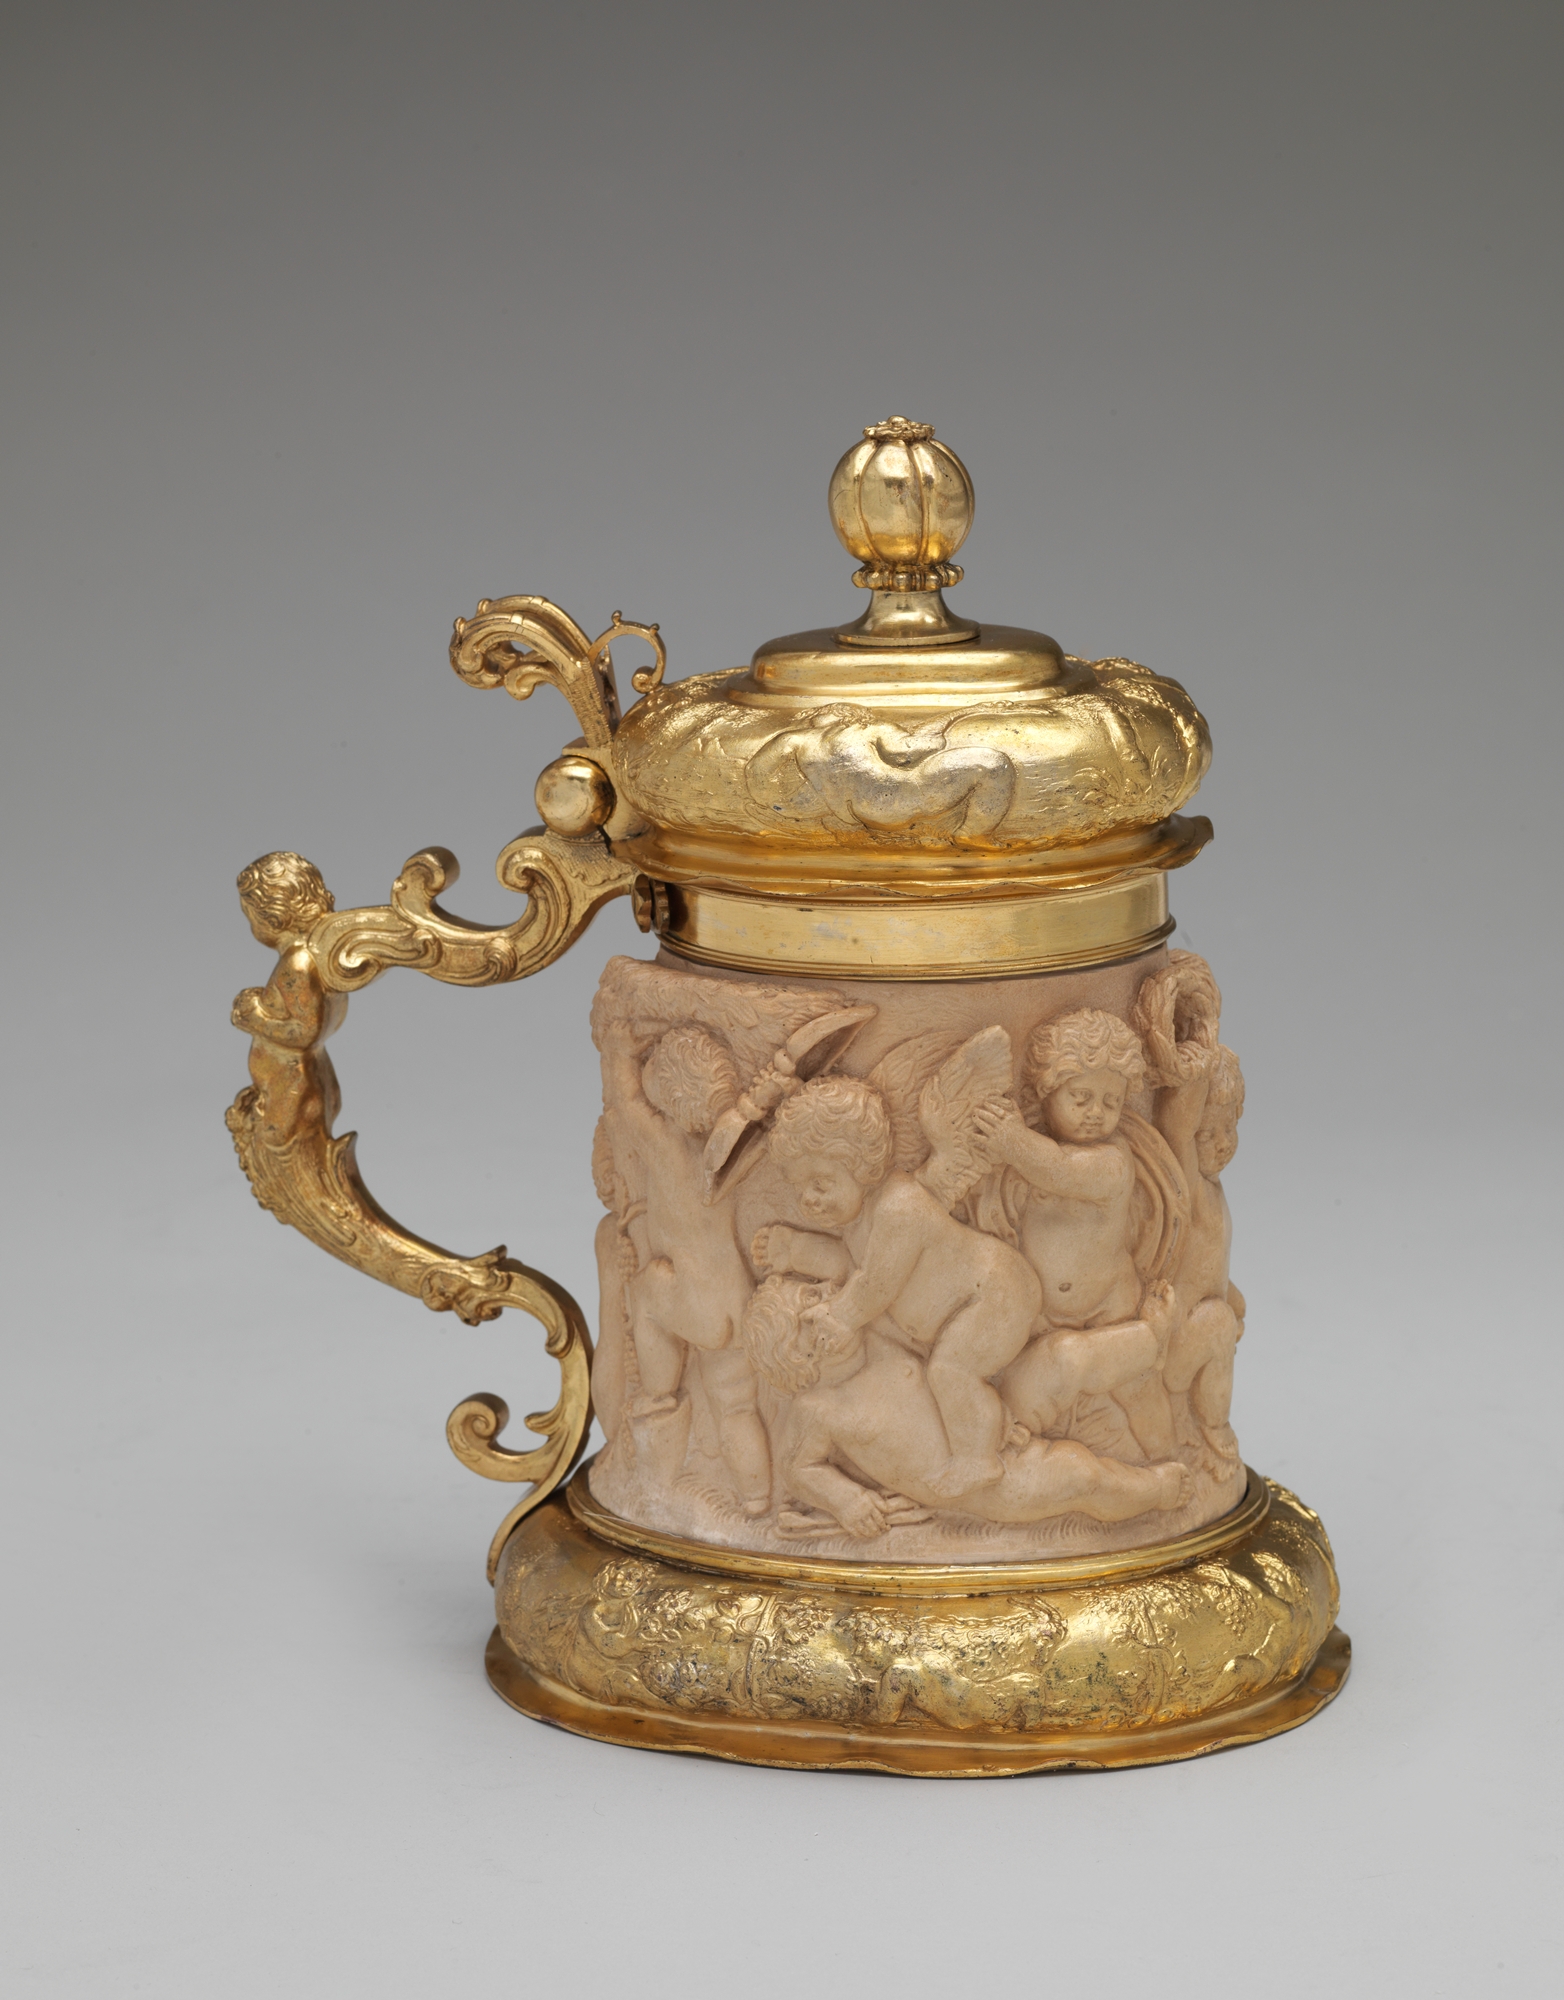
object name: tankard with cover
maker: elkington & co.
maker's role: manufacturer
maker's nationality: british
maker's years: 1829-1963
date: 1801-1900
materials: ivory, metal, silver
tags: caryatids,bacchantes,putti,rams